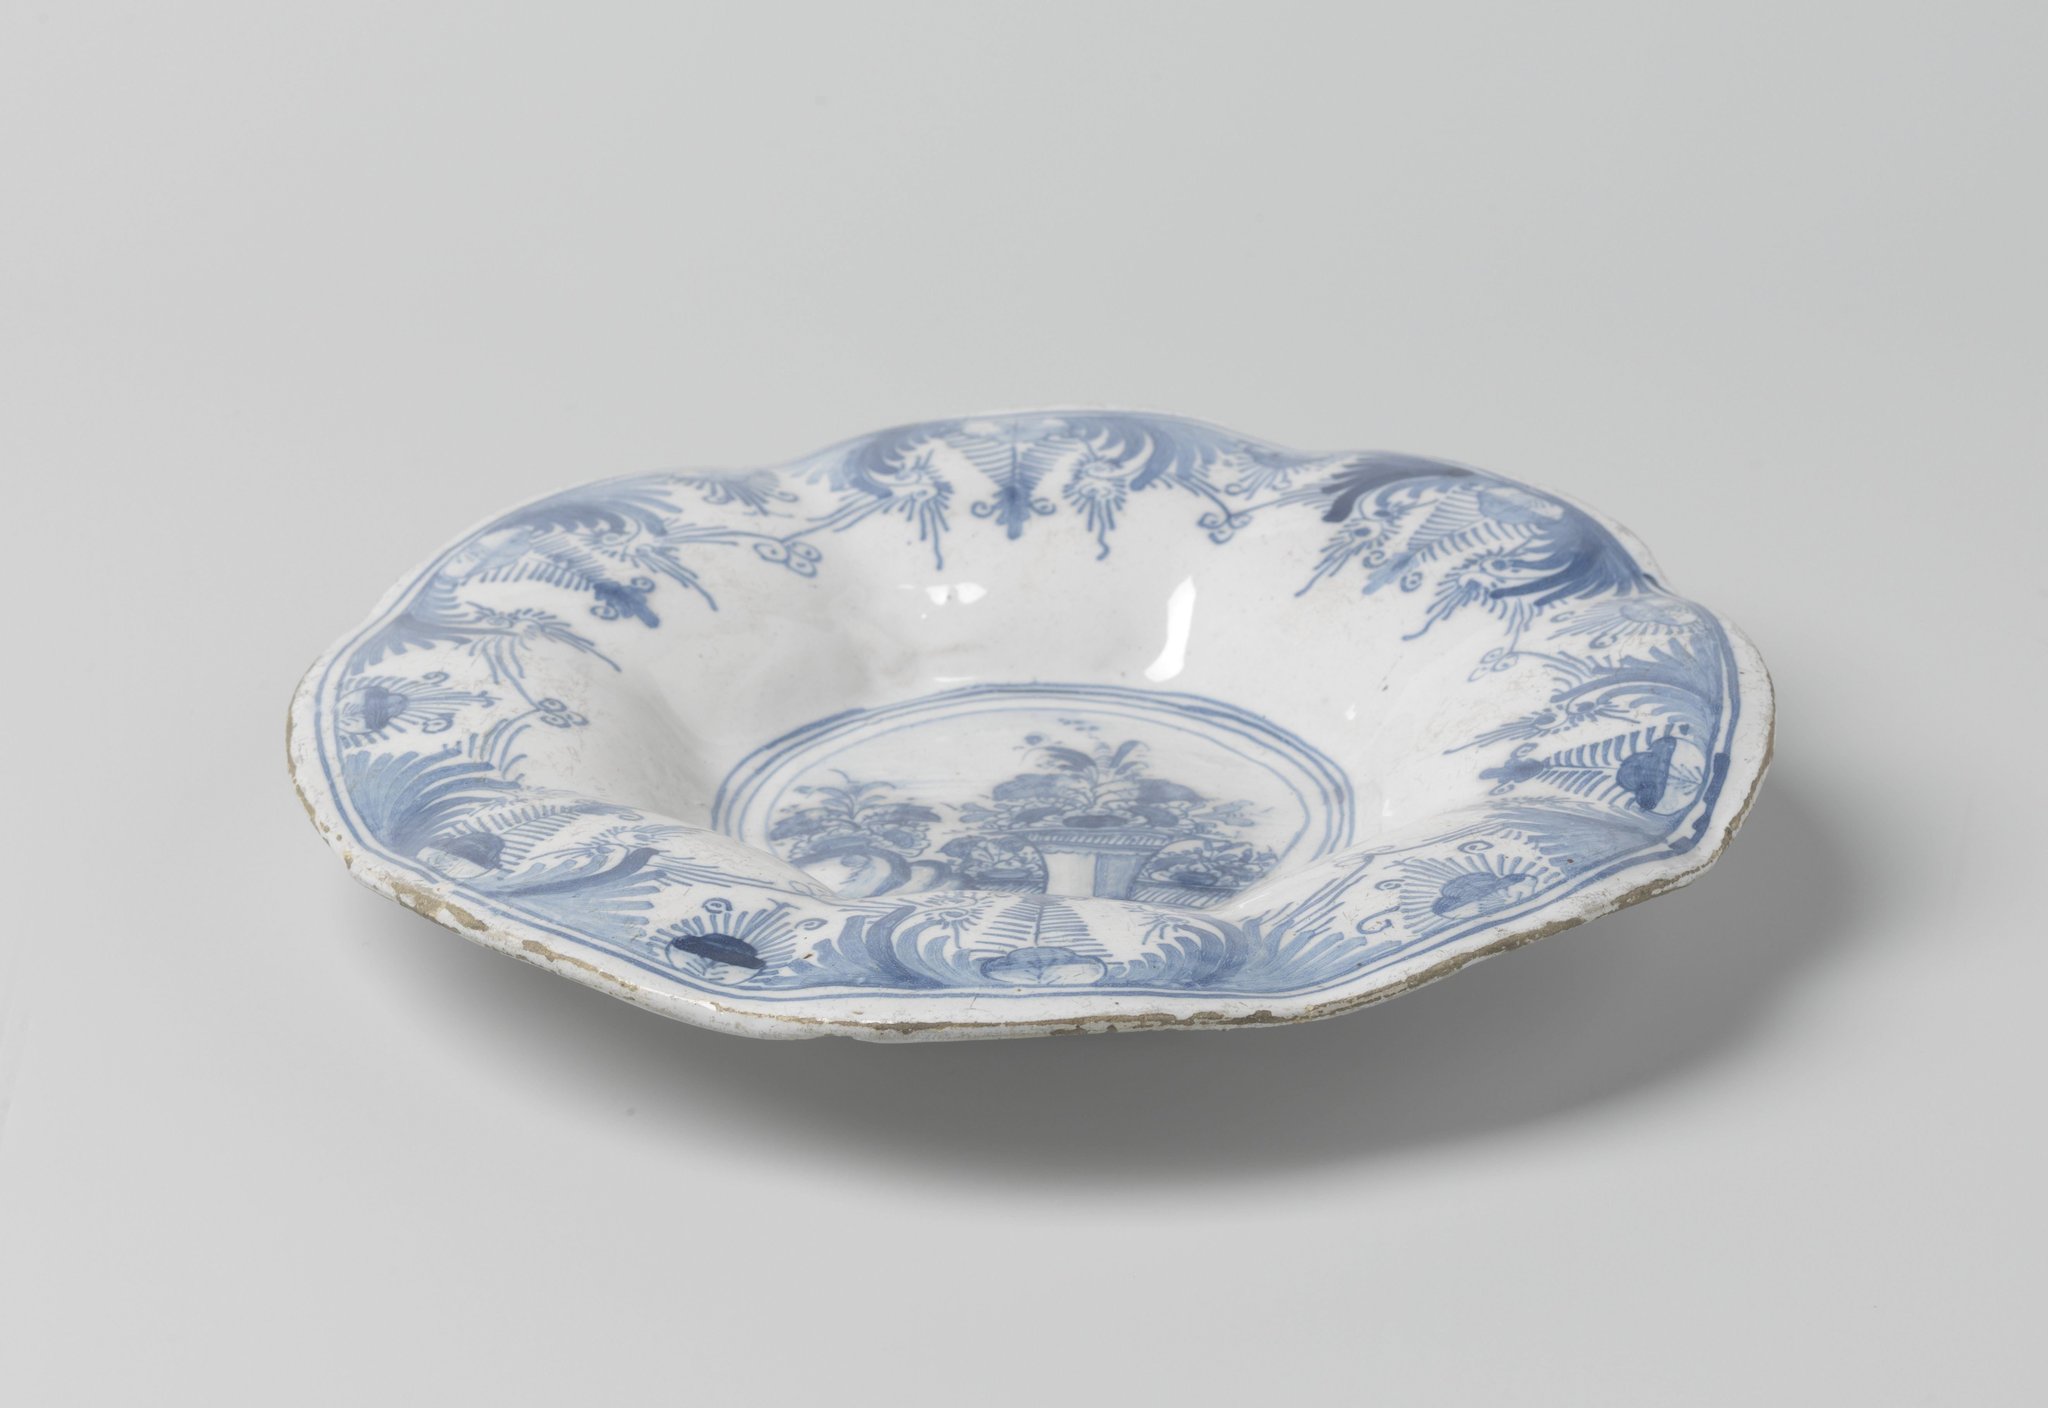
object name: platter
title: Bord, achtlobbig, beschilderd met vaas met bloemen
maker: Anonymous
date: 1720-1740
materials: earthenware, glaze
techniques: painted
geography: bayreuth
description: Achtlobbige schotel van blauw beschilderde faience. Op het plat is een grond met bloemen geschilderd waarop een vaas met bloemen staat. Langs de rand zijn gestileerde bladeren geschilderd. De schotel is gemerkt.